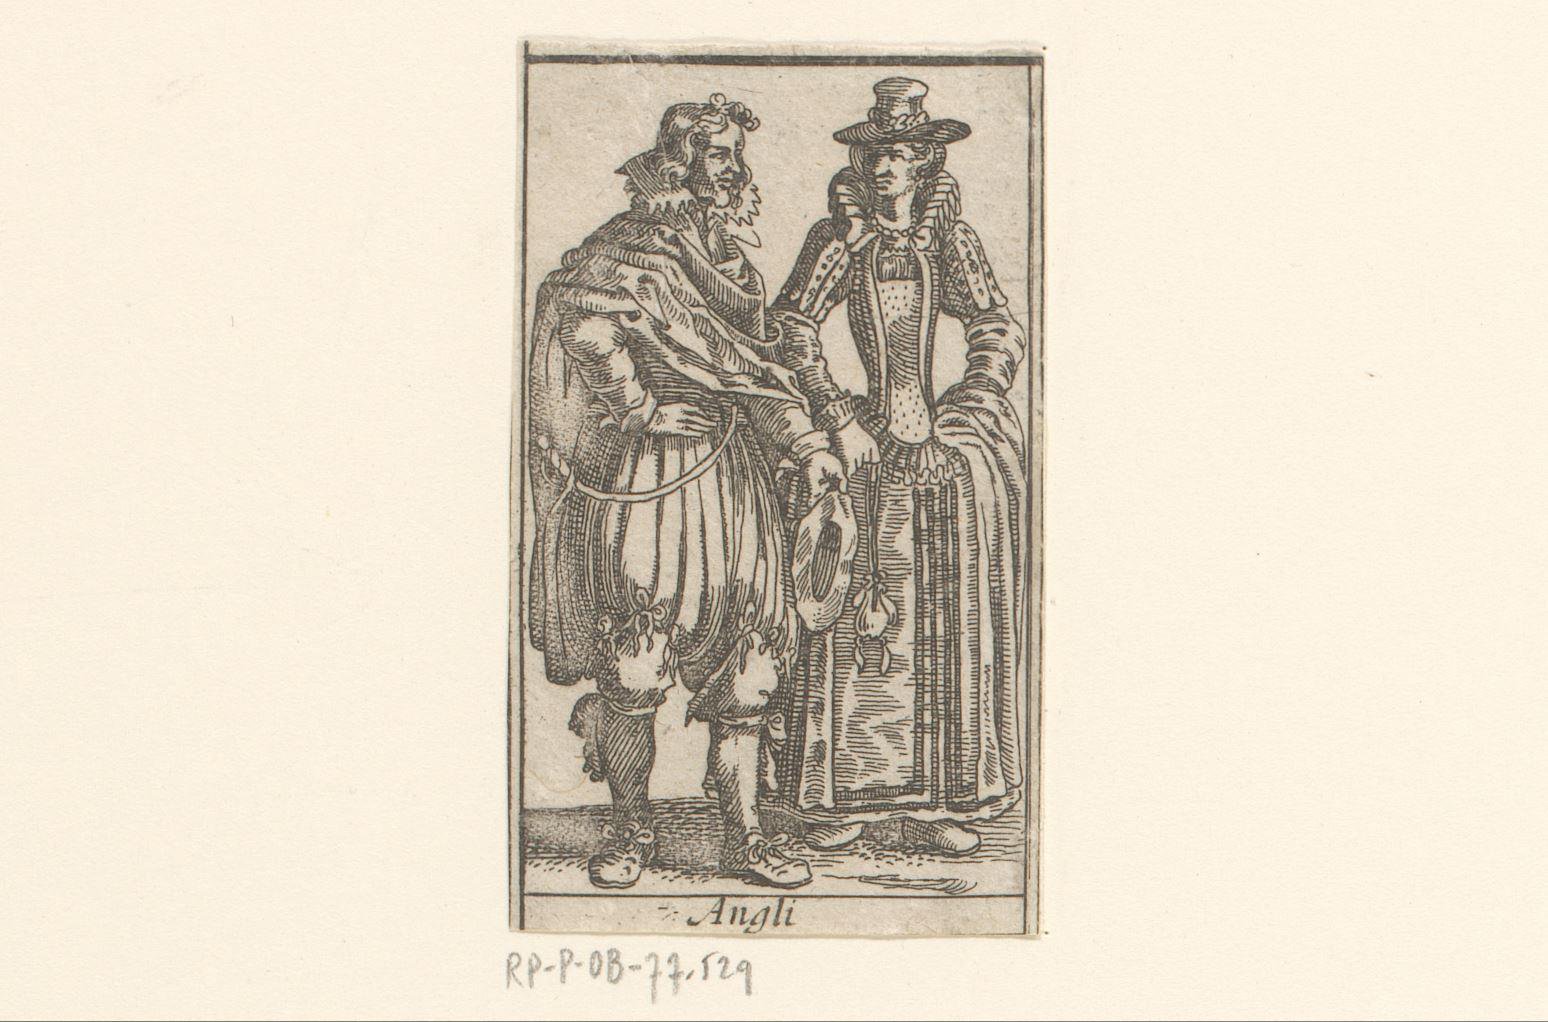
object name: costume print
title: Man en vrouw in Engelse mode van rond 1610-1620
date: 1617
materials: paper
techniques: etching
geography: amsterdam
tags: europeans: englishmen (+ costume), clothes, costume, england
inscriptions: collector's mark: Lugt 2228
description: Prent is geknipt van de kaart van Europa van Willem Jansz. Blaeu uit 1617.